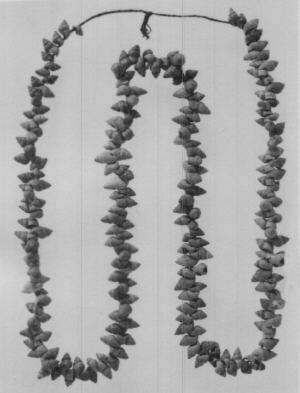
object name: necklace rattle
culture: african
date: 1850-1889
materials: shell